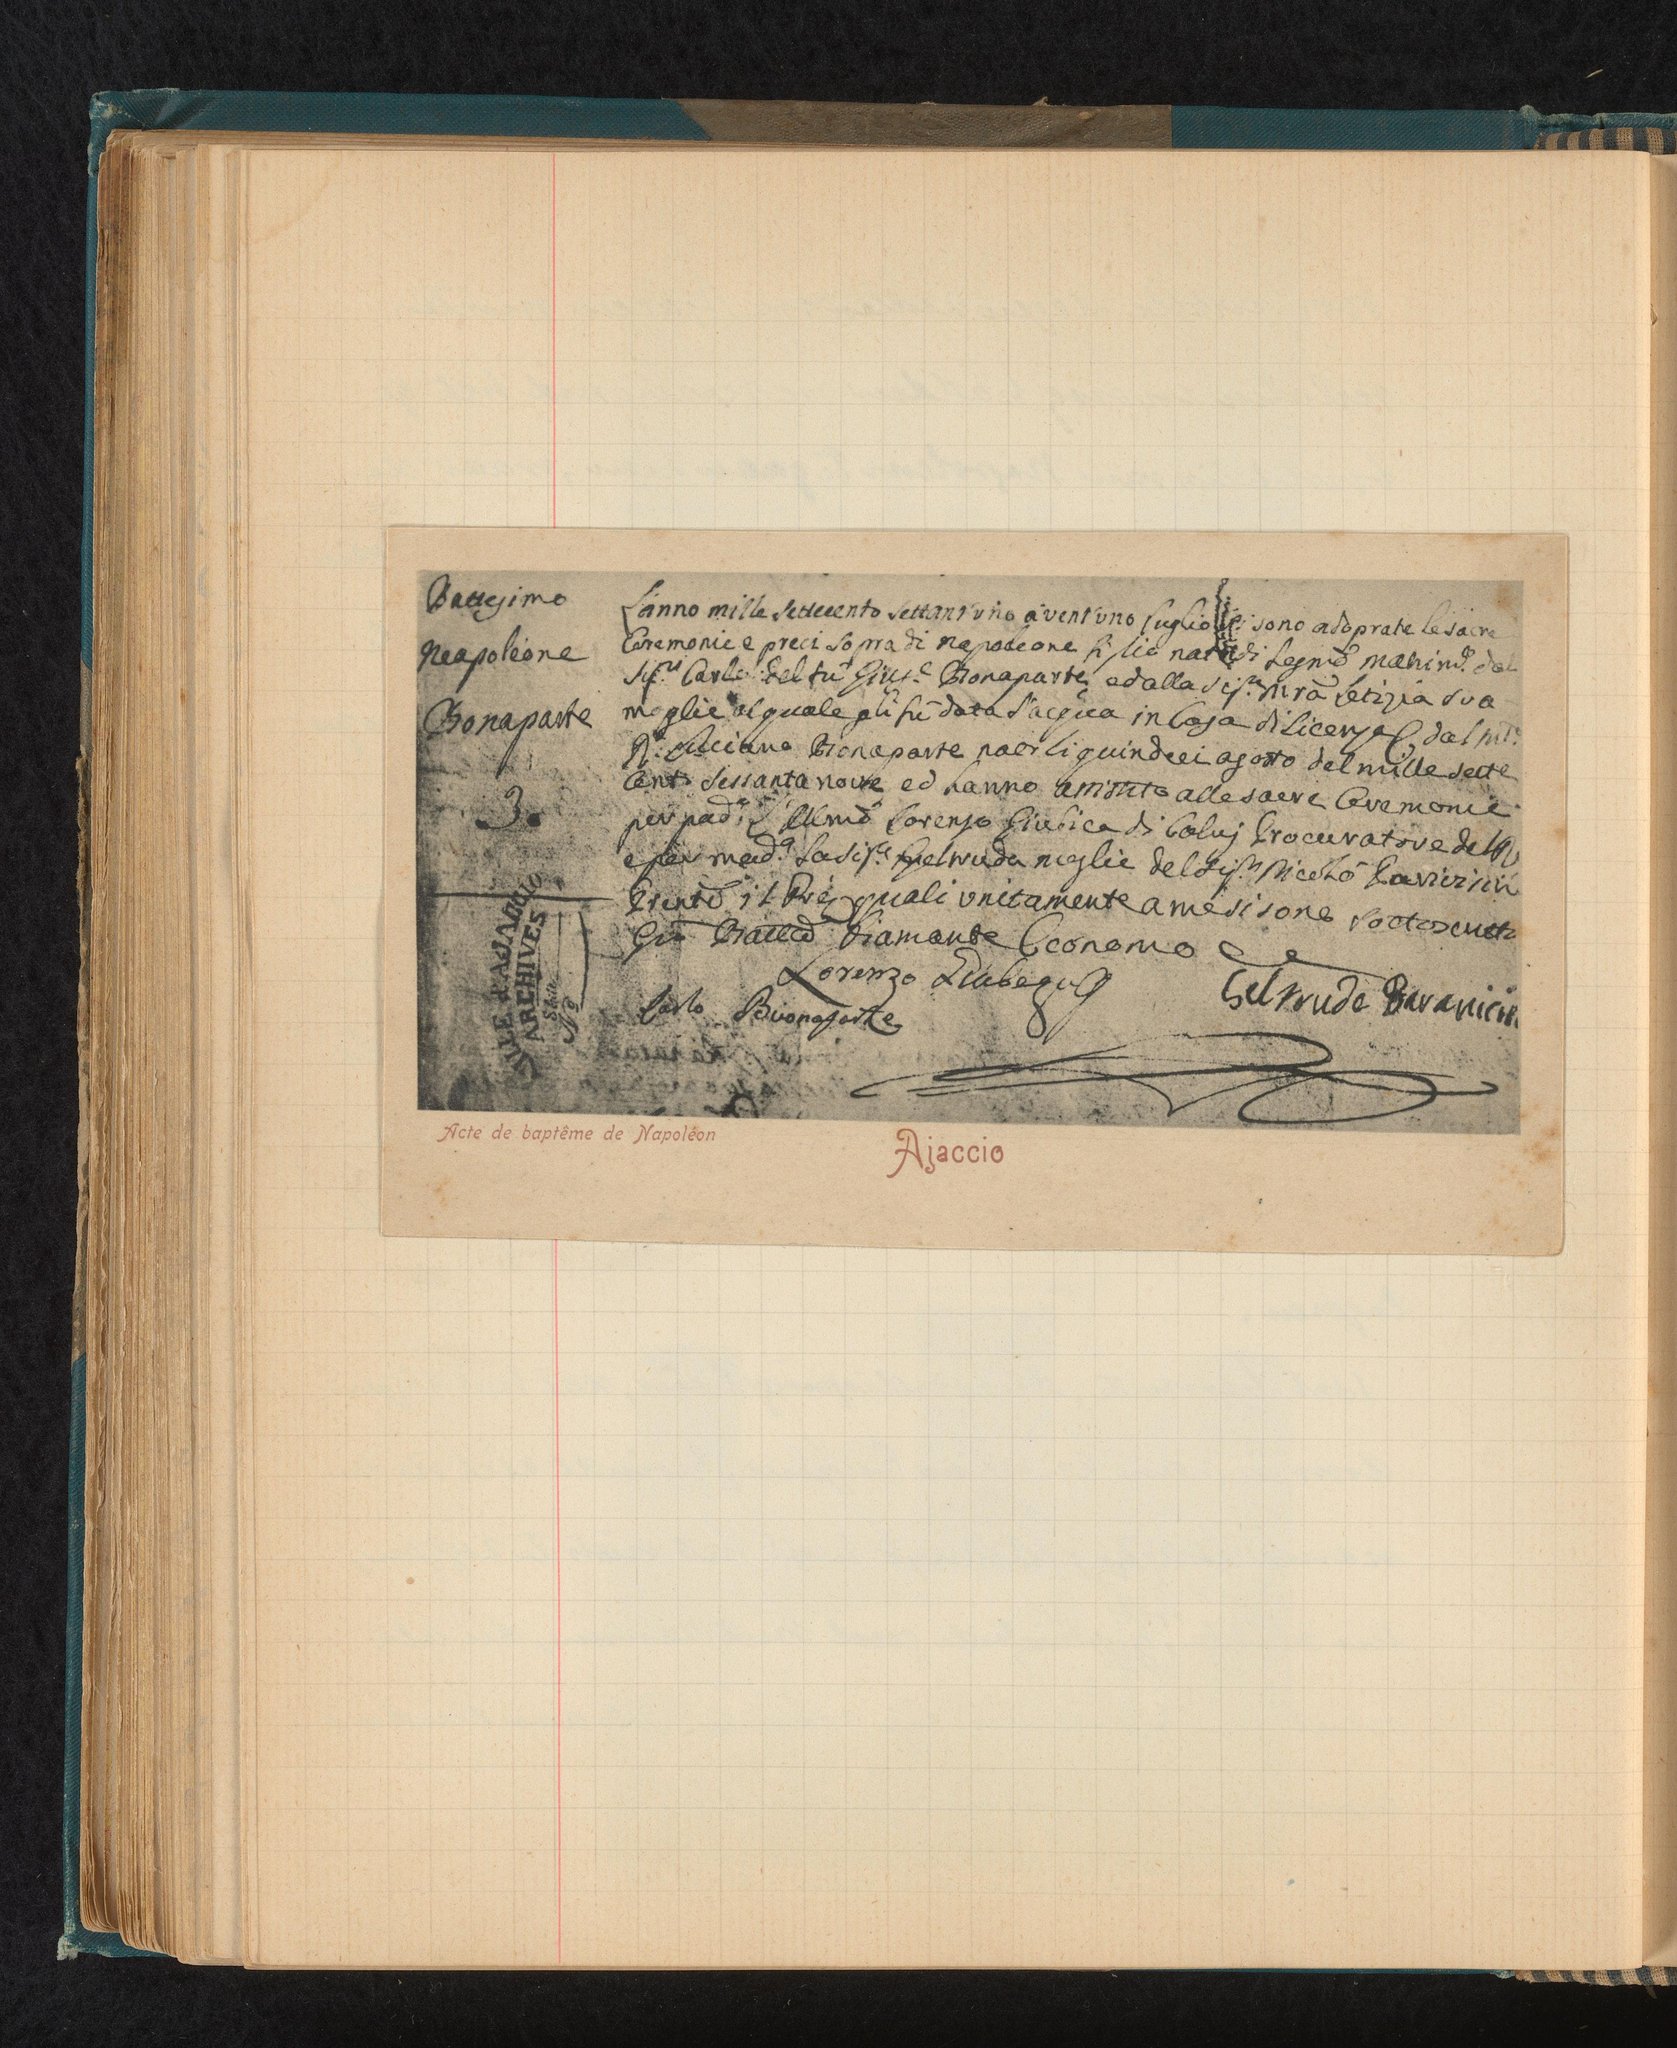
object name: album leaf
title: Reproductie van de doopakte van Napoleon Bonaparte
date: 1902-1904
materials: cardboard, paper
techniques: photograph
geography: ajaccio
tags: baptism, christening ceremony ~ the first of the seven sacraments, handwriting, written text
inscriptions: inscription: ‘Acte de baptême de Napoleon/ Ajaccio’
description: Deze fotomechanische afdruk maakt deel uit van een album.